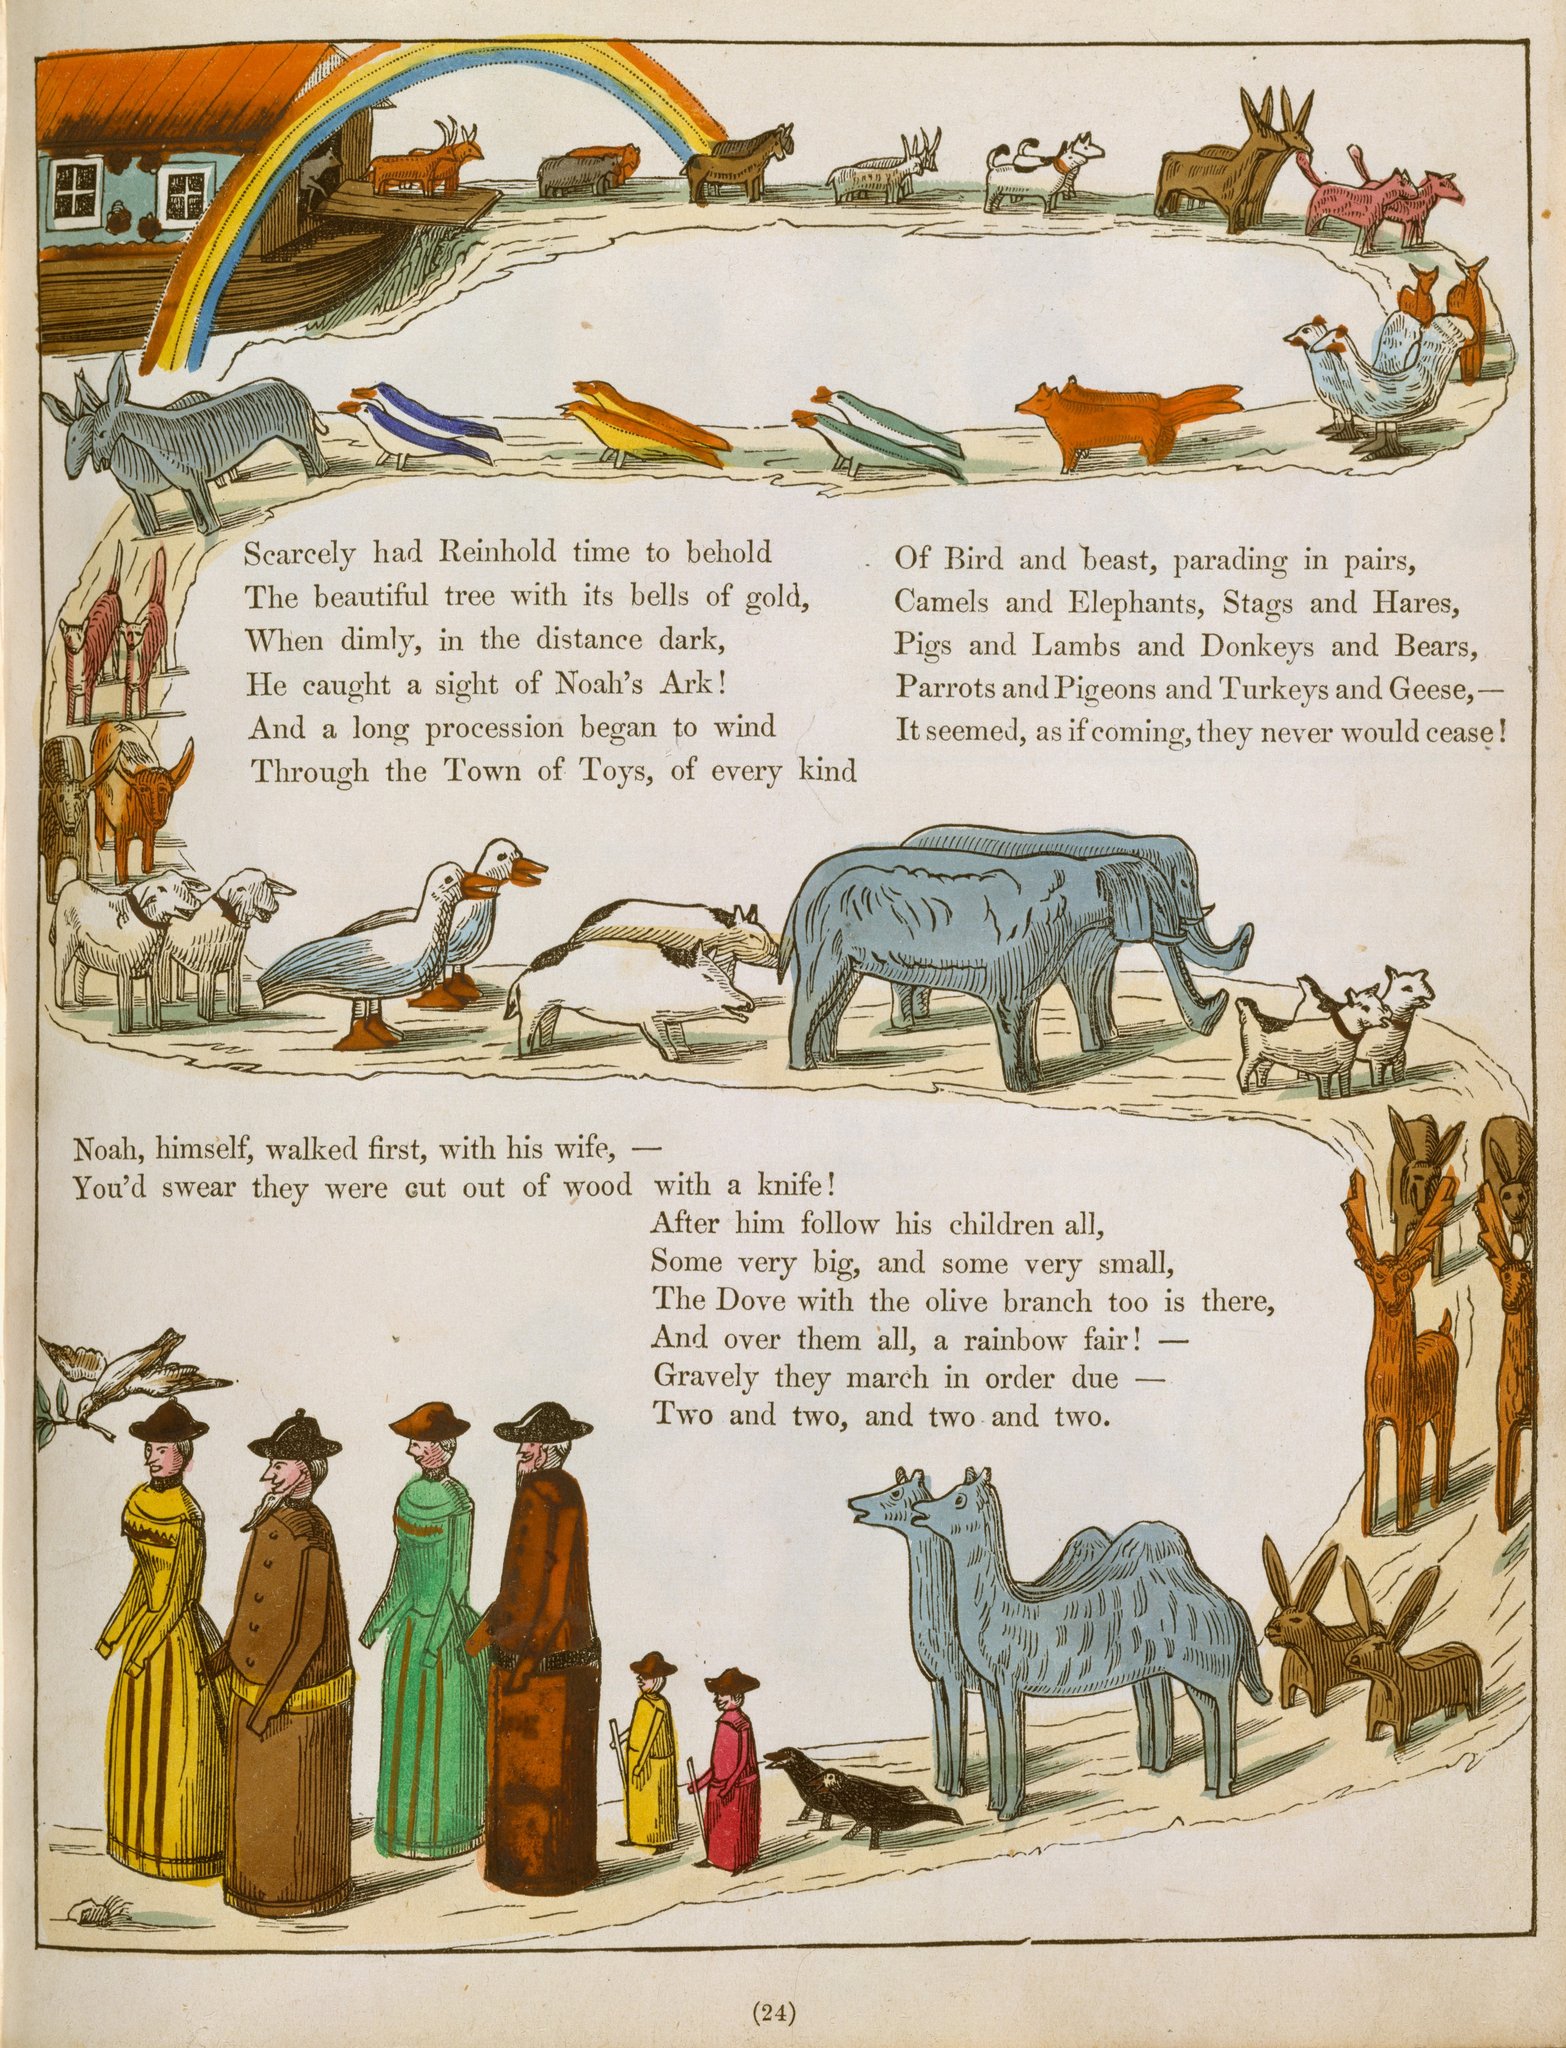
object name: book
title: King Nut-Cracker Or The Dream of Poor Reinhold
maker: dr. heinrich hoffmann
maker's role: author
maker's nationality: german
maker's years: 1809-1894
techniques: hand coloring, engraving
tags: deer,elephants,rabbits,rainbows